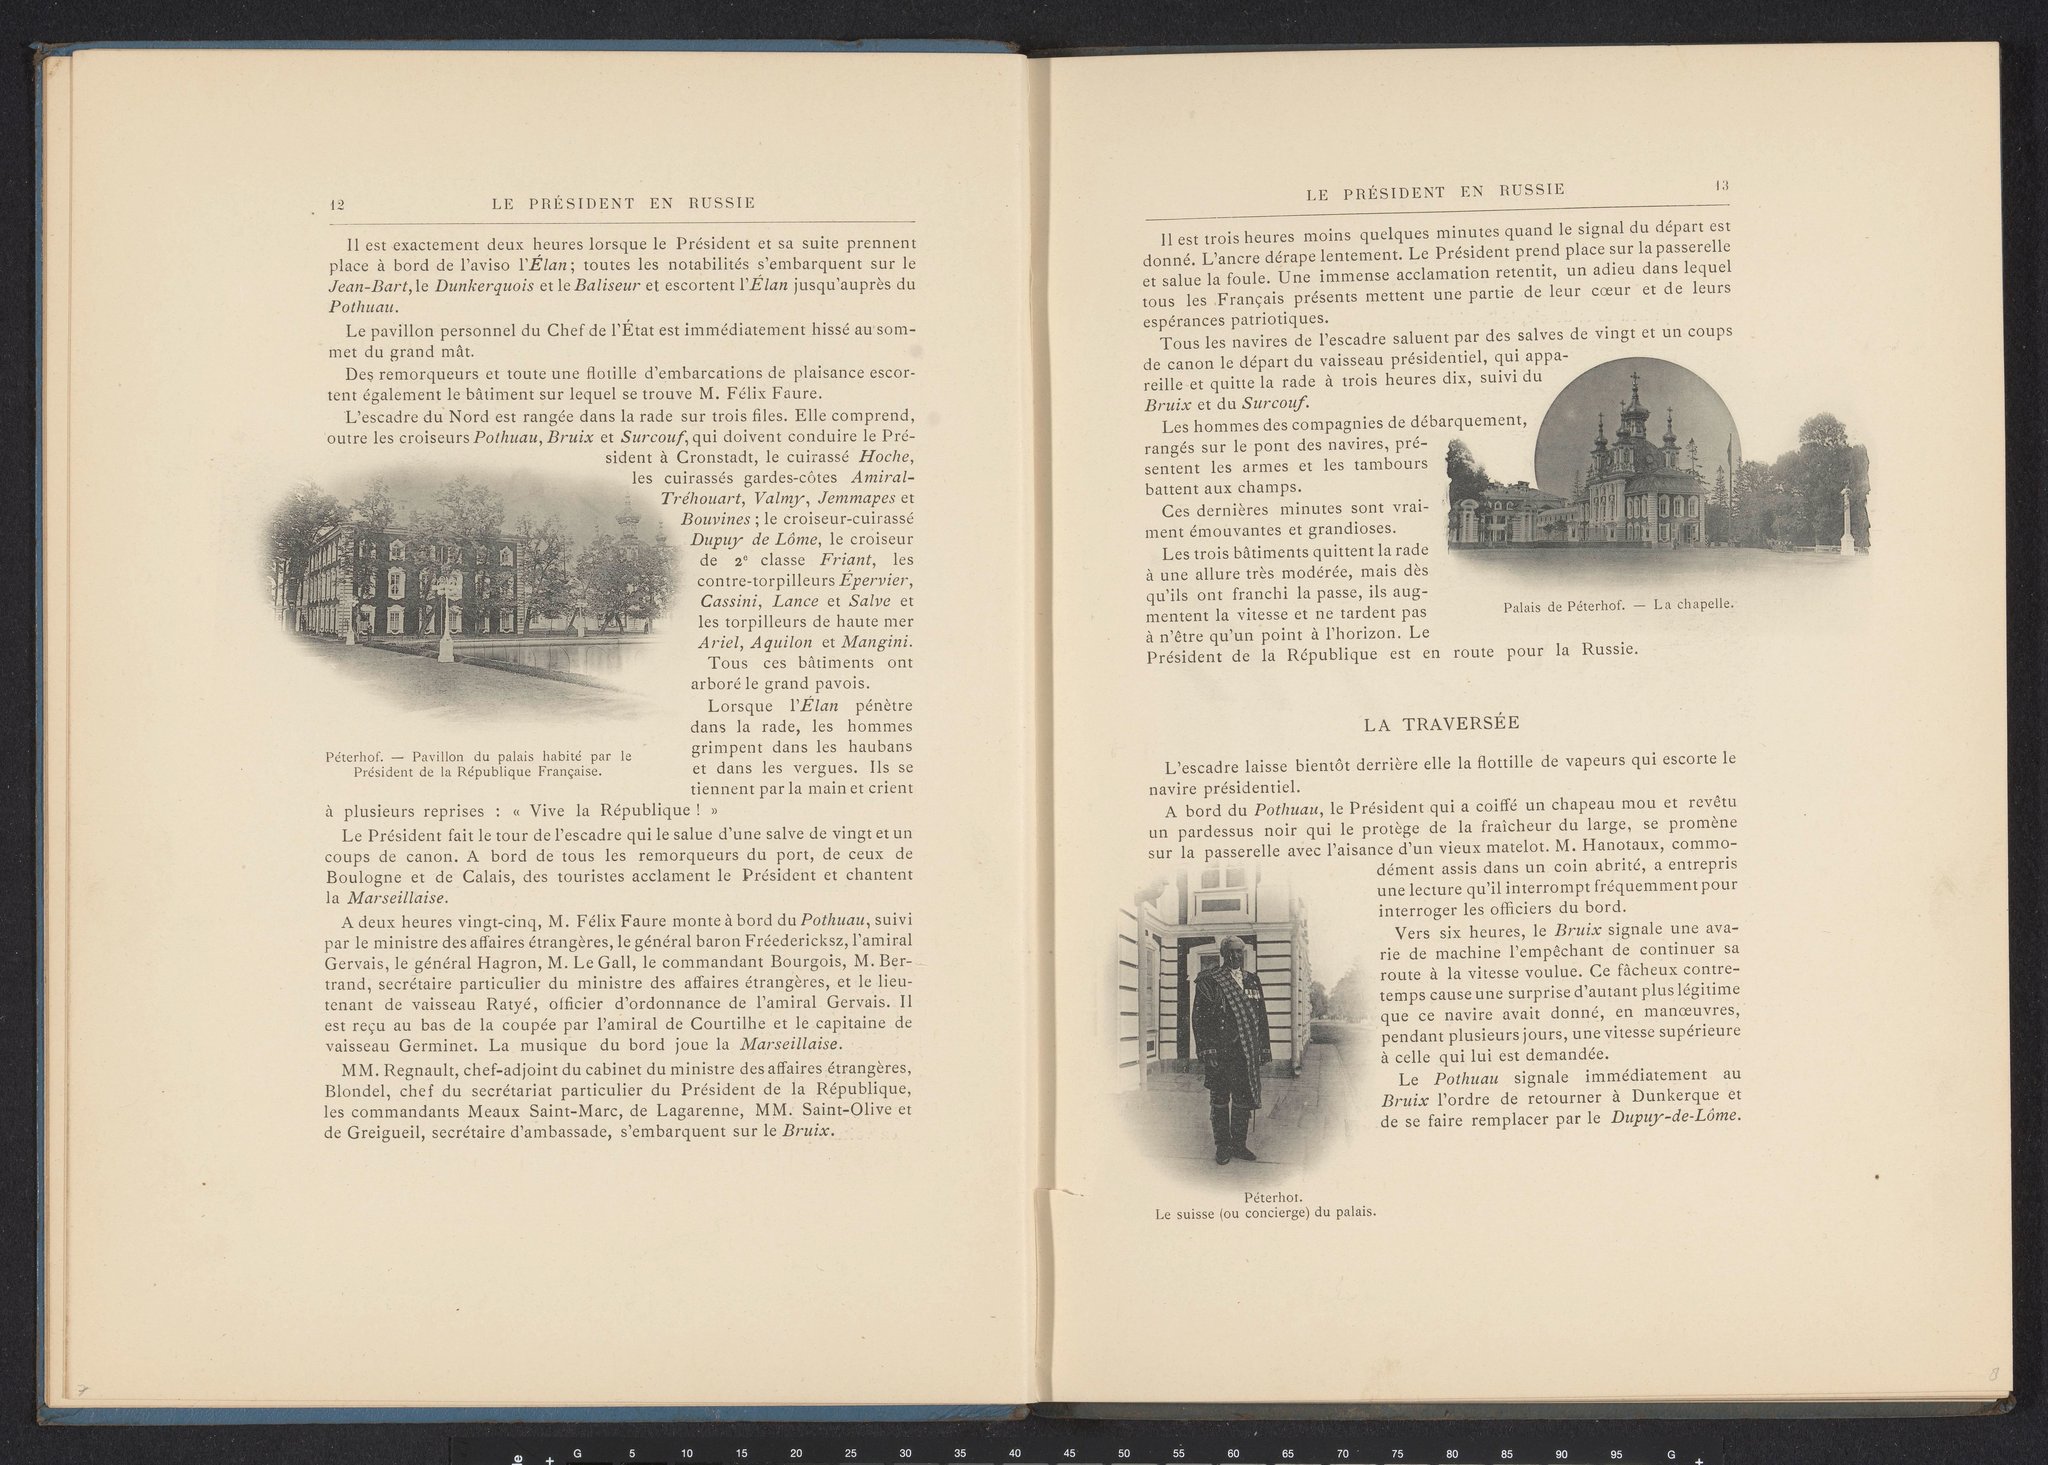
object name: page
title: Gezicht op de kapel van het paleizencomplex van Peterhof en de conciërge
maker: Anonymous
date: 1897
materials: paper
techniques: photograph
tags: house-guard, doorkeeper, janitor, church (exterior) - qq - small church, chapel, façade (of house or building)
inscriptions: inscription: ‘Palais de Péterhof (...) du palais.’